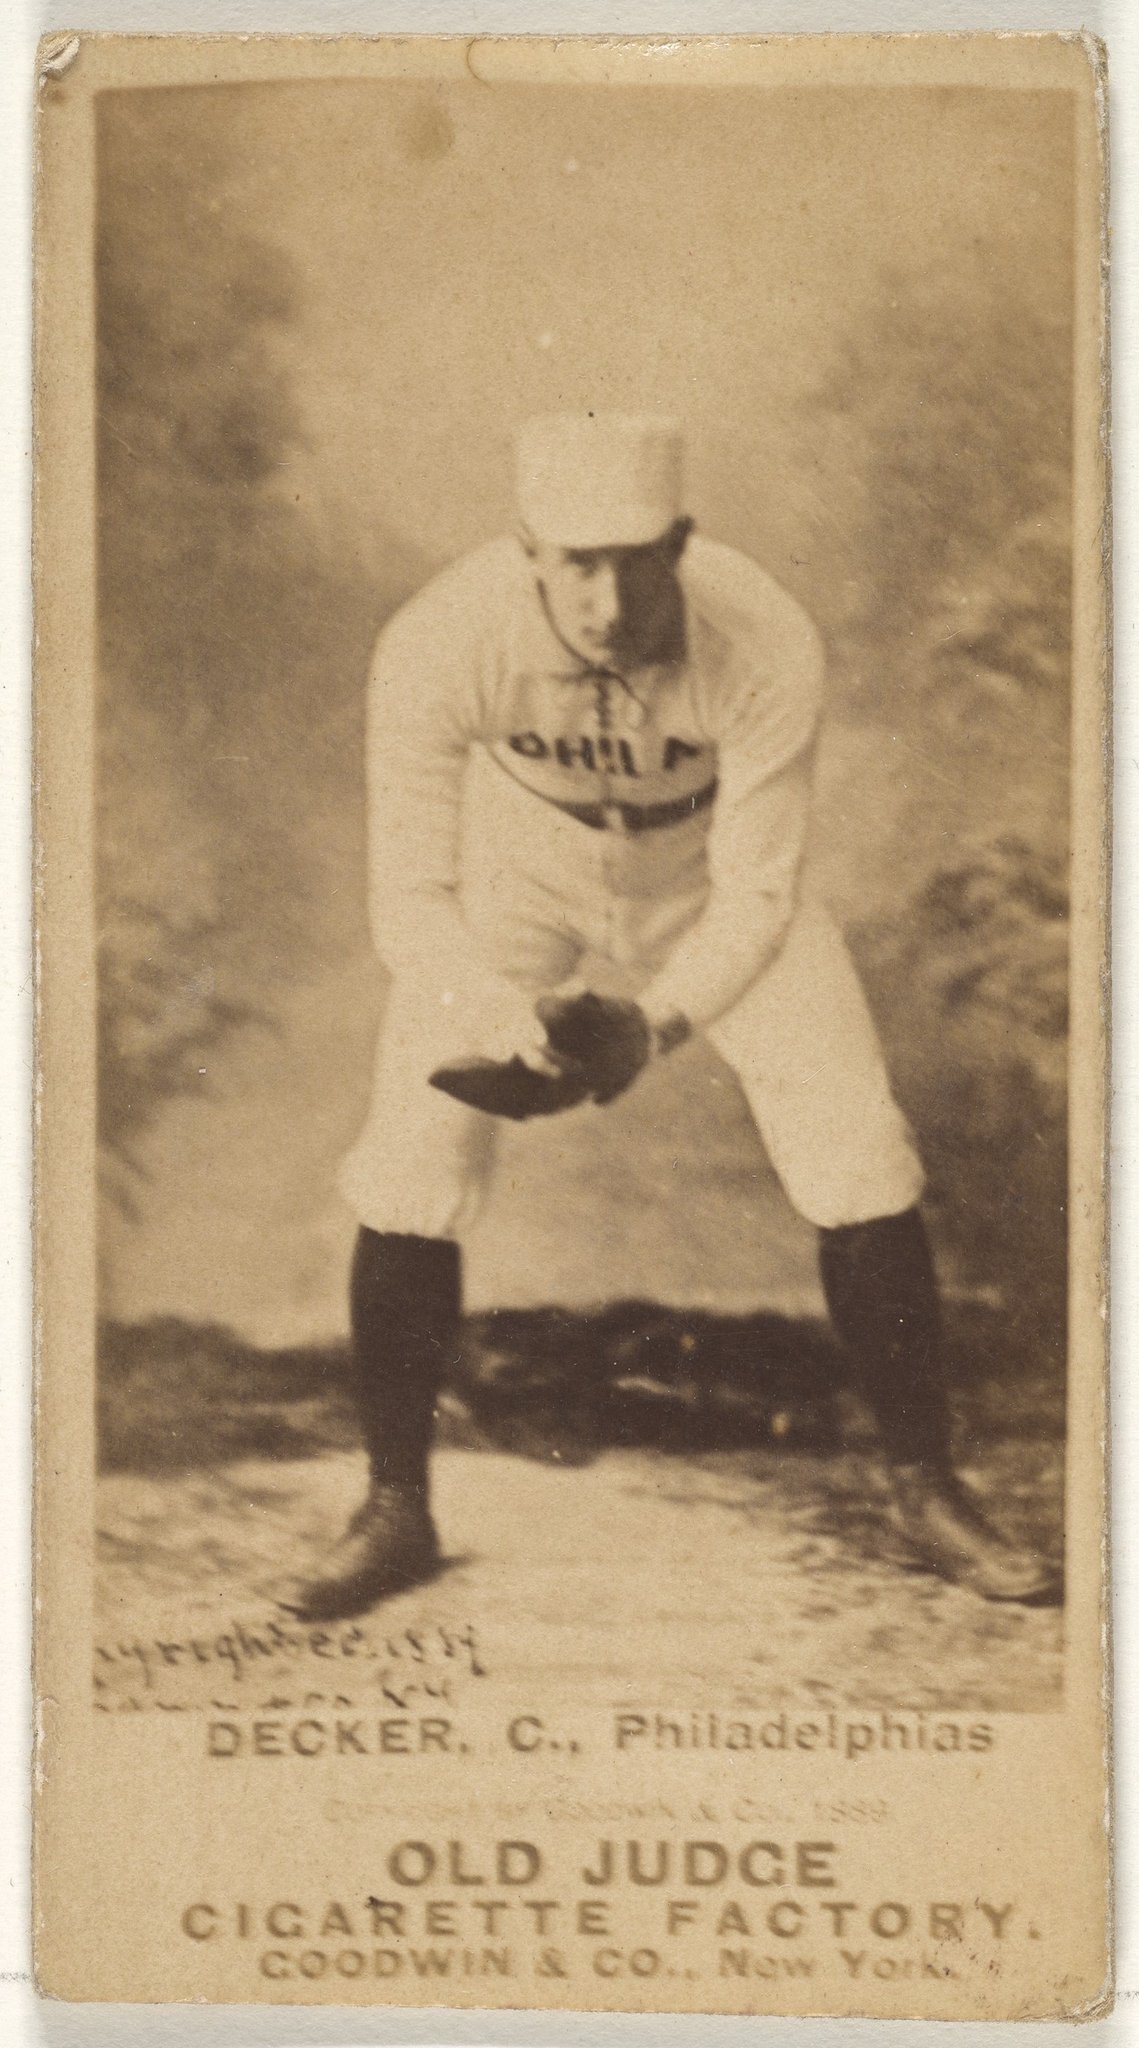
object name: baseball card, photograph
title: Decker, Catcher, Philadelphia, from the Old Judge series (N172) for Old Judge Cigarettes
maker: goodwin & company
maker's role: publisher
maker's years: 1850-1950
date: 1889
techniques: albumen silver print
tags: men,portraits,baseball,athletes